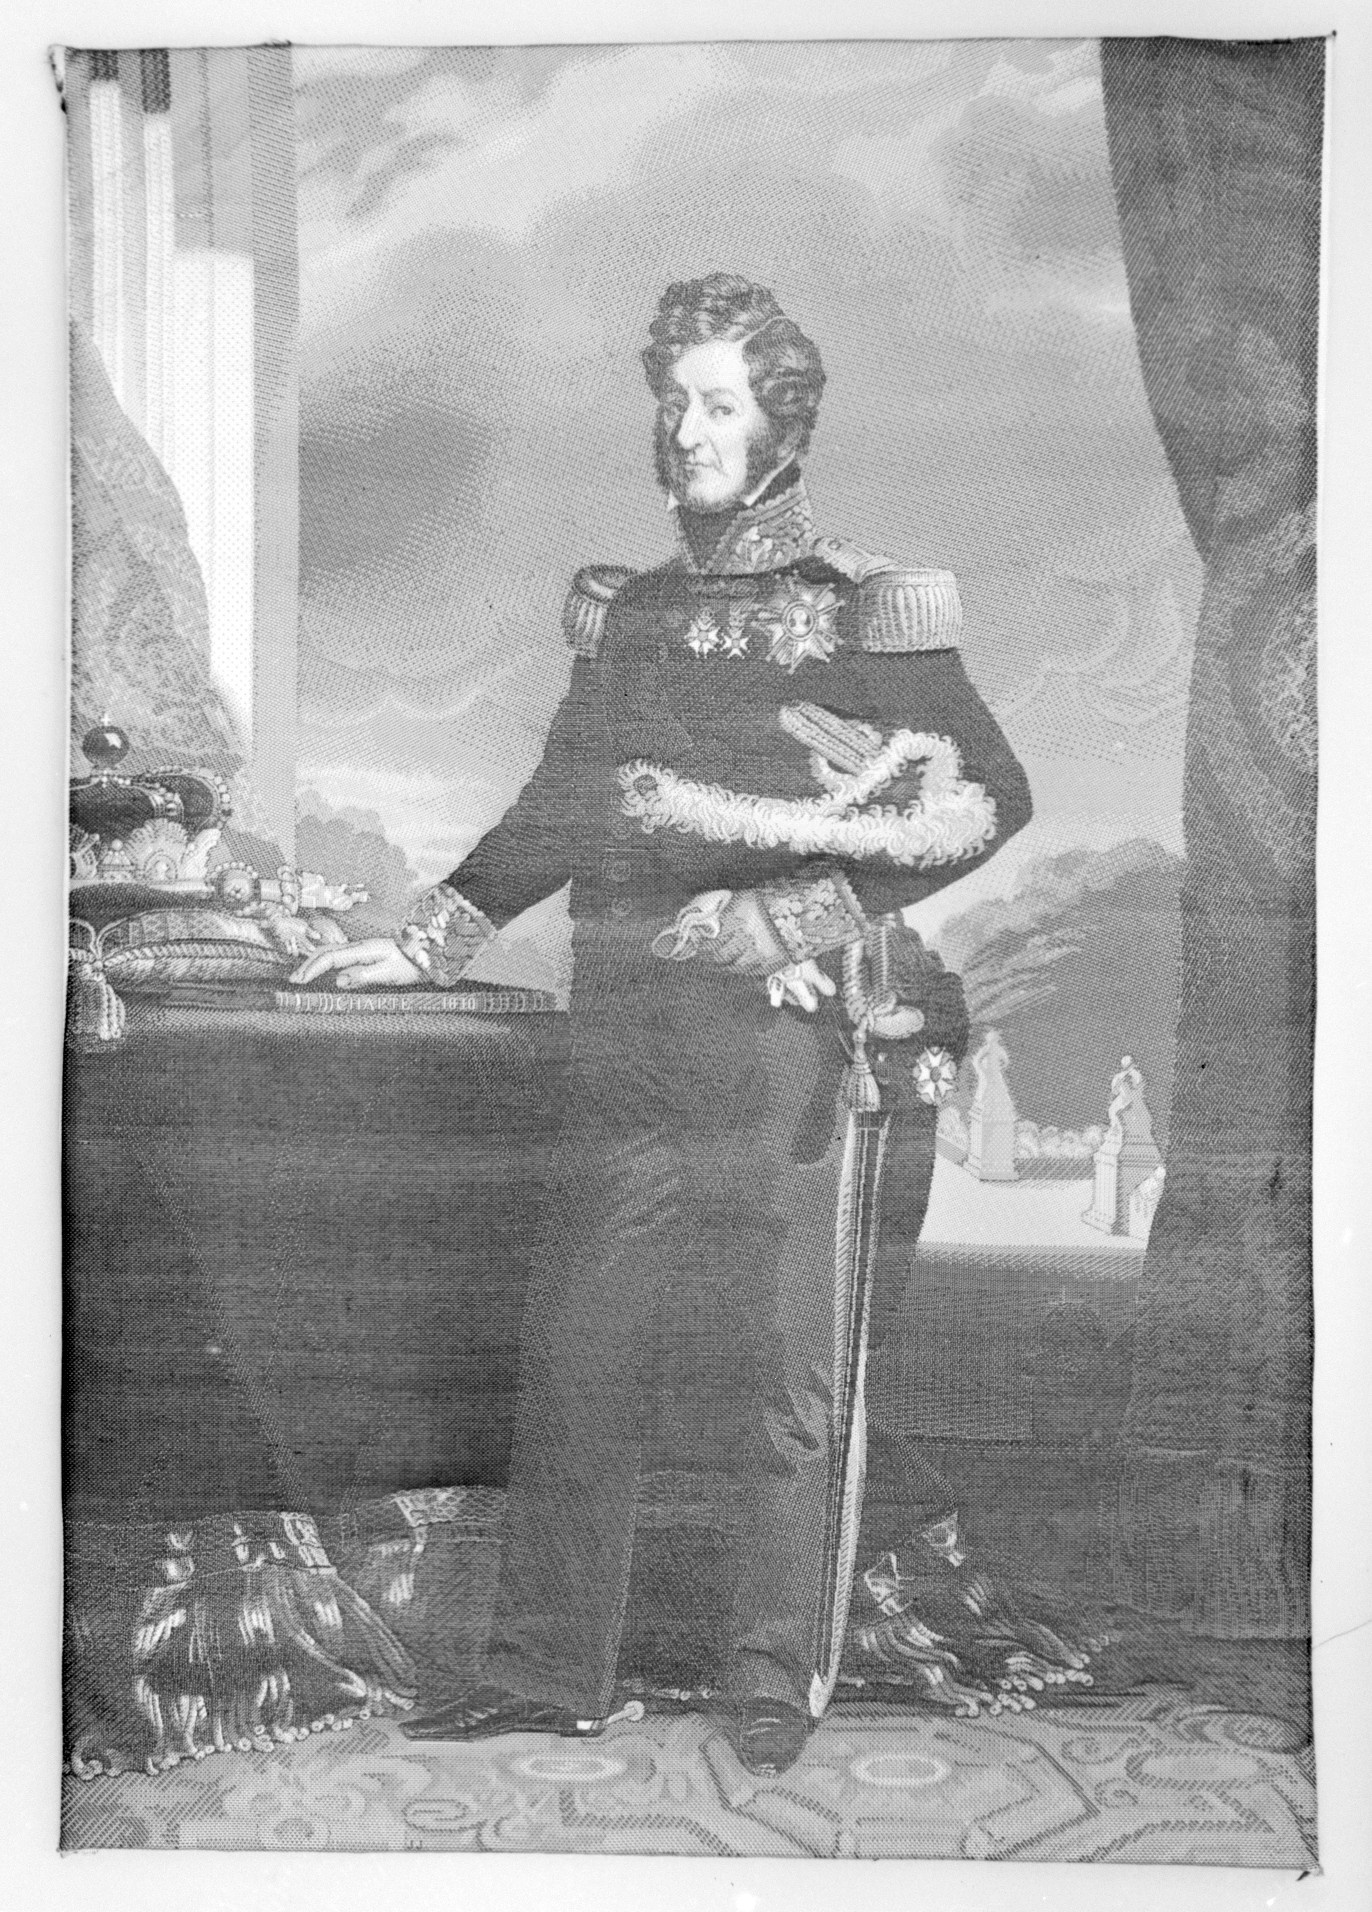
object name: portrait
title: Louis-Philippe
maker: verzier, bonnart et cie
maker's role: manufactory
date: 1839-1848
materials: silk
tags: men,portraits